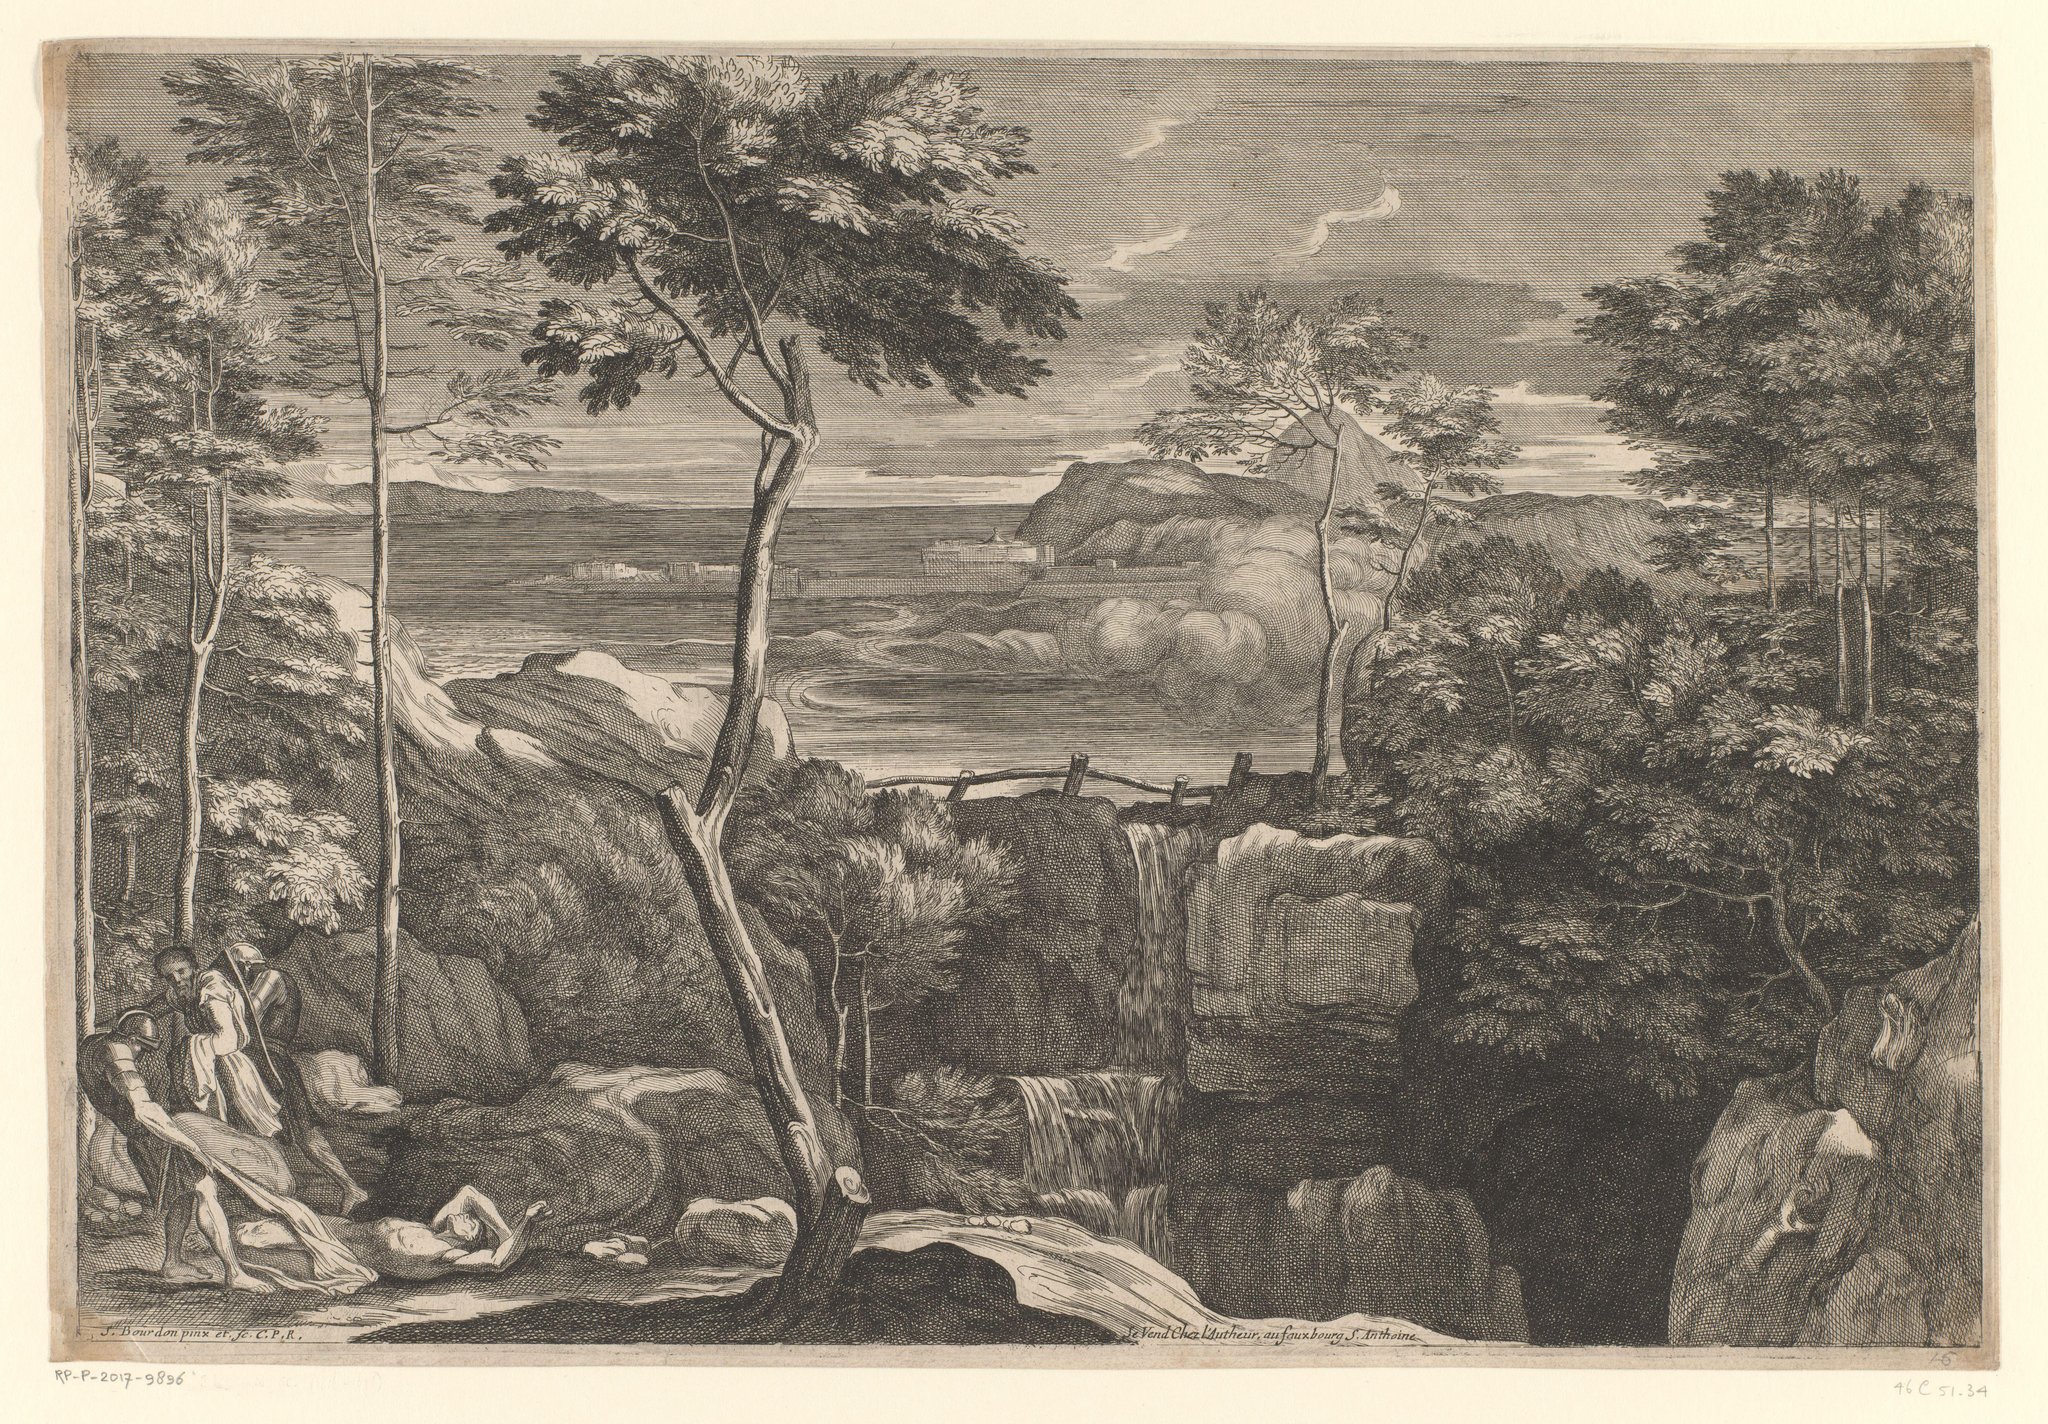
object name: print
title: Landschappen met Bijbelse taferelen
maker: sébastien bourdon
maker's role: draughtsman, painter, print maker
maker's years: 1616-1671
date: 1626-1671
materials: paper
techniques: etching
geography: paris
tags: landscapes, the traveller is attacked by robbers ~ parable of the good samaritan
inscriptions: collector's mark: Lugt 2228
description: Maakt deel uit van een serie van twaalf prenten van landschappen met enkele Bijbelse taferelen.